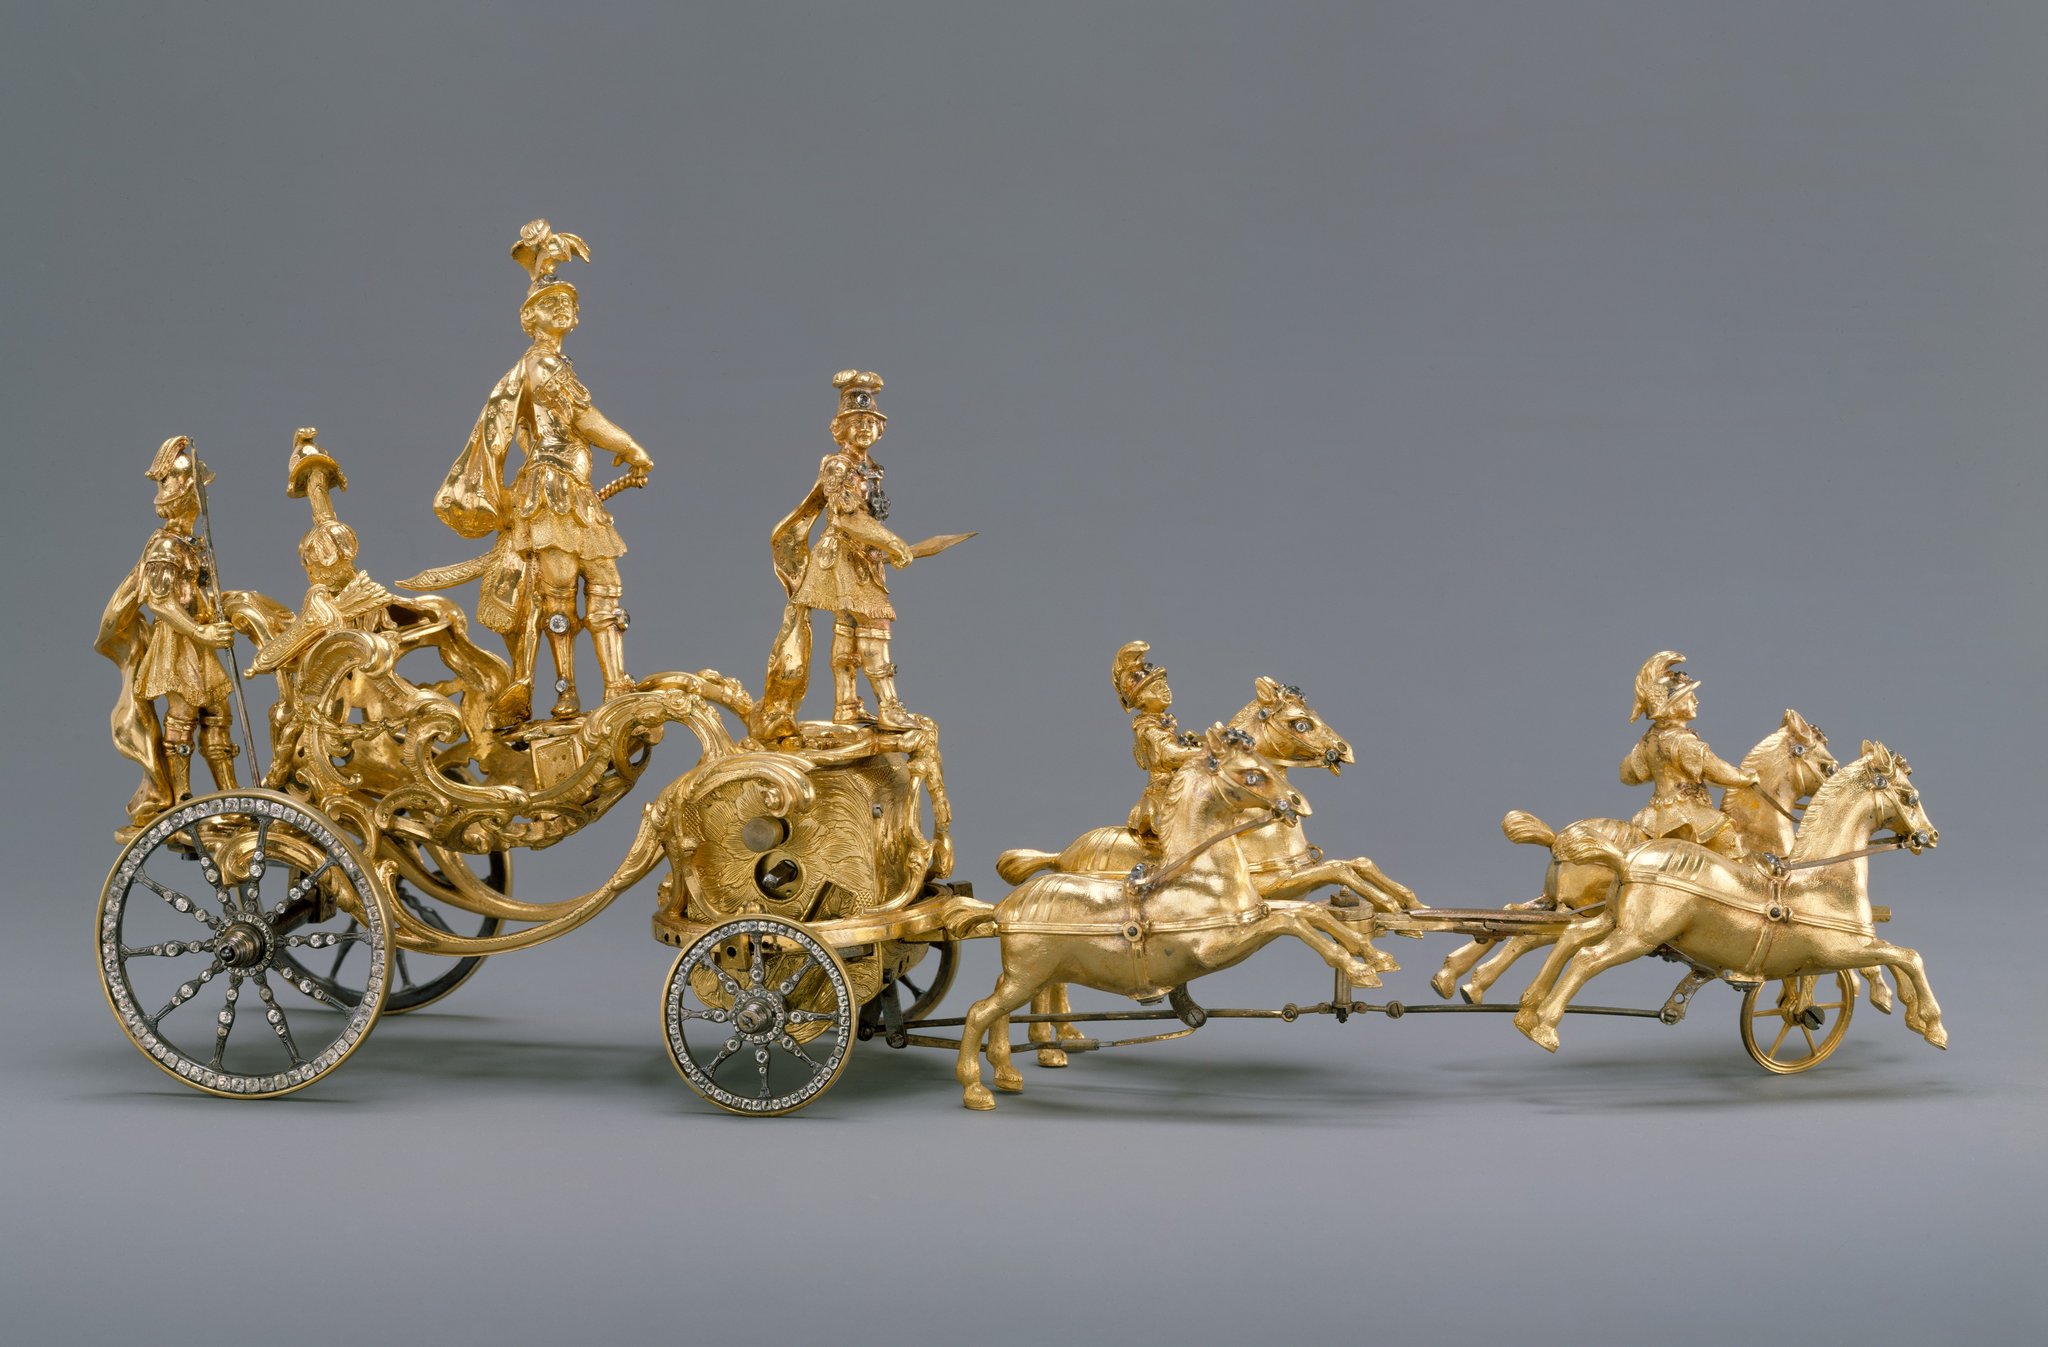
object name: automaton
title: Automaton in the Form of a Triumphal Chariot Drawn by Four Horses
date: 1760-1770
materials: gilt bronze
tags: men,horses,chariots